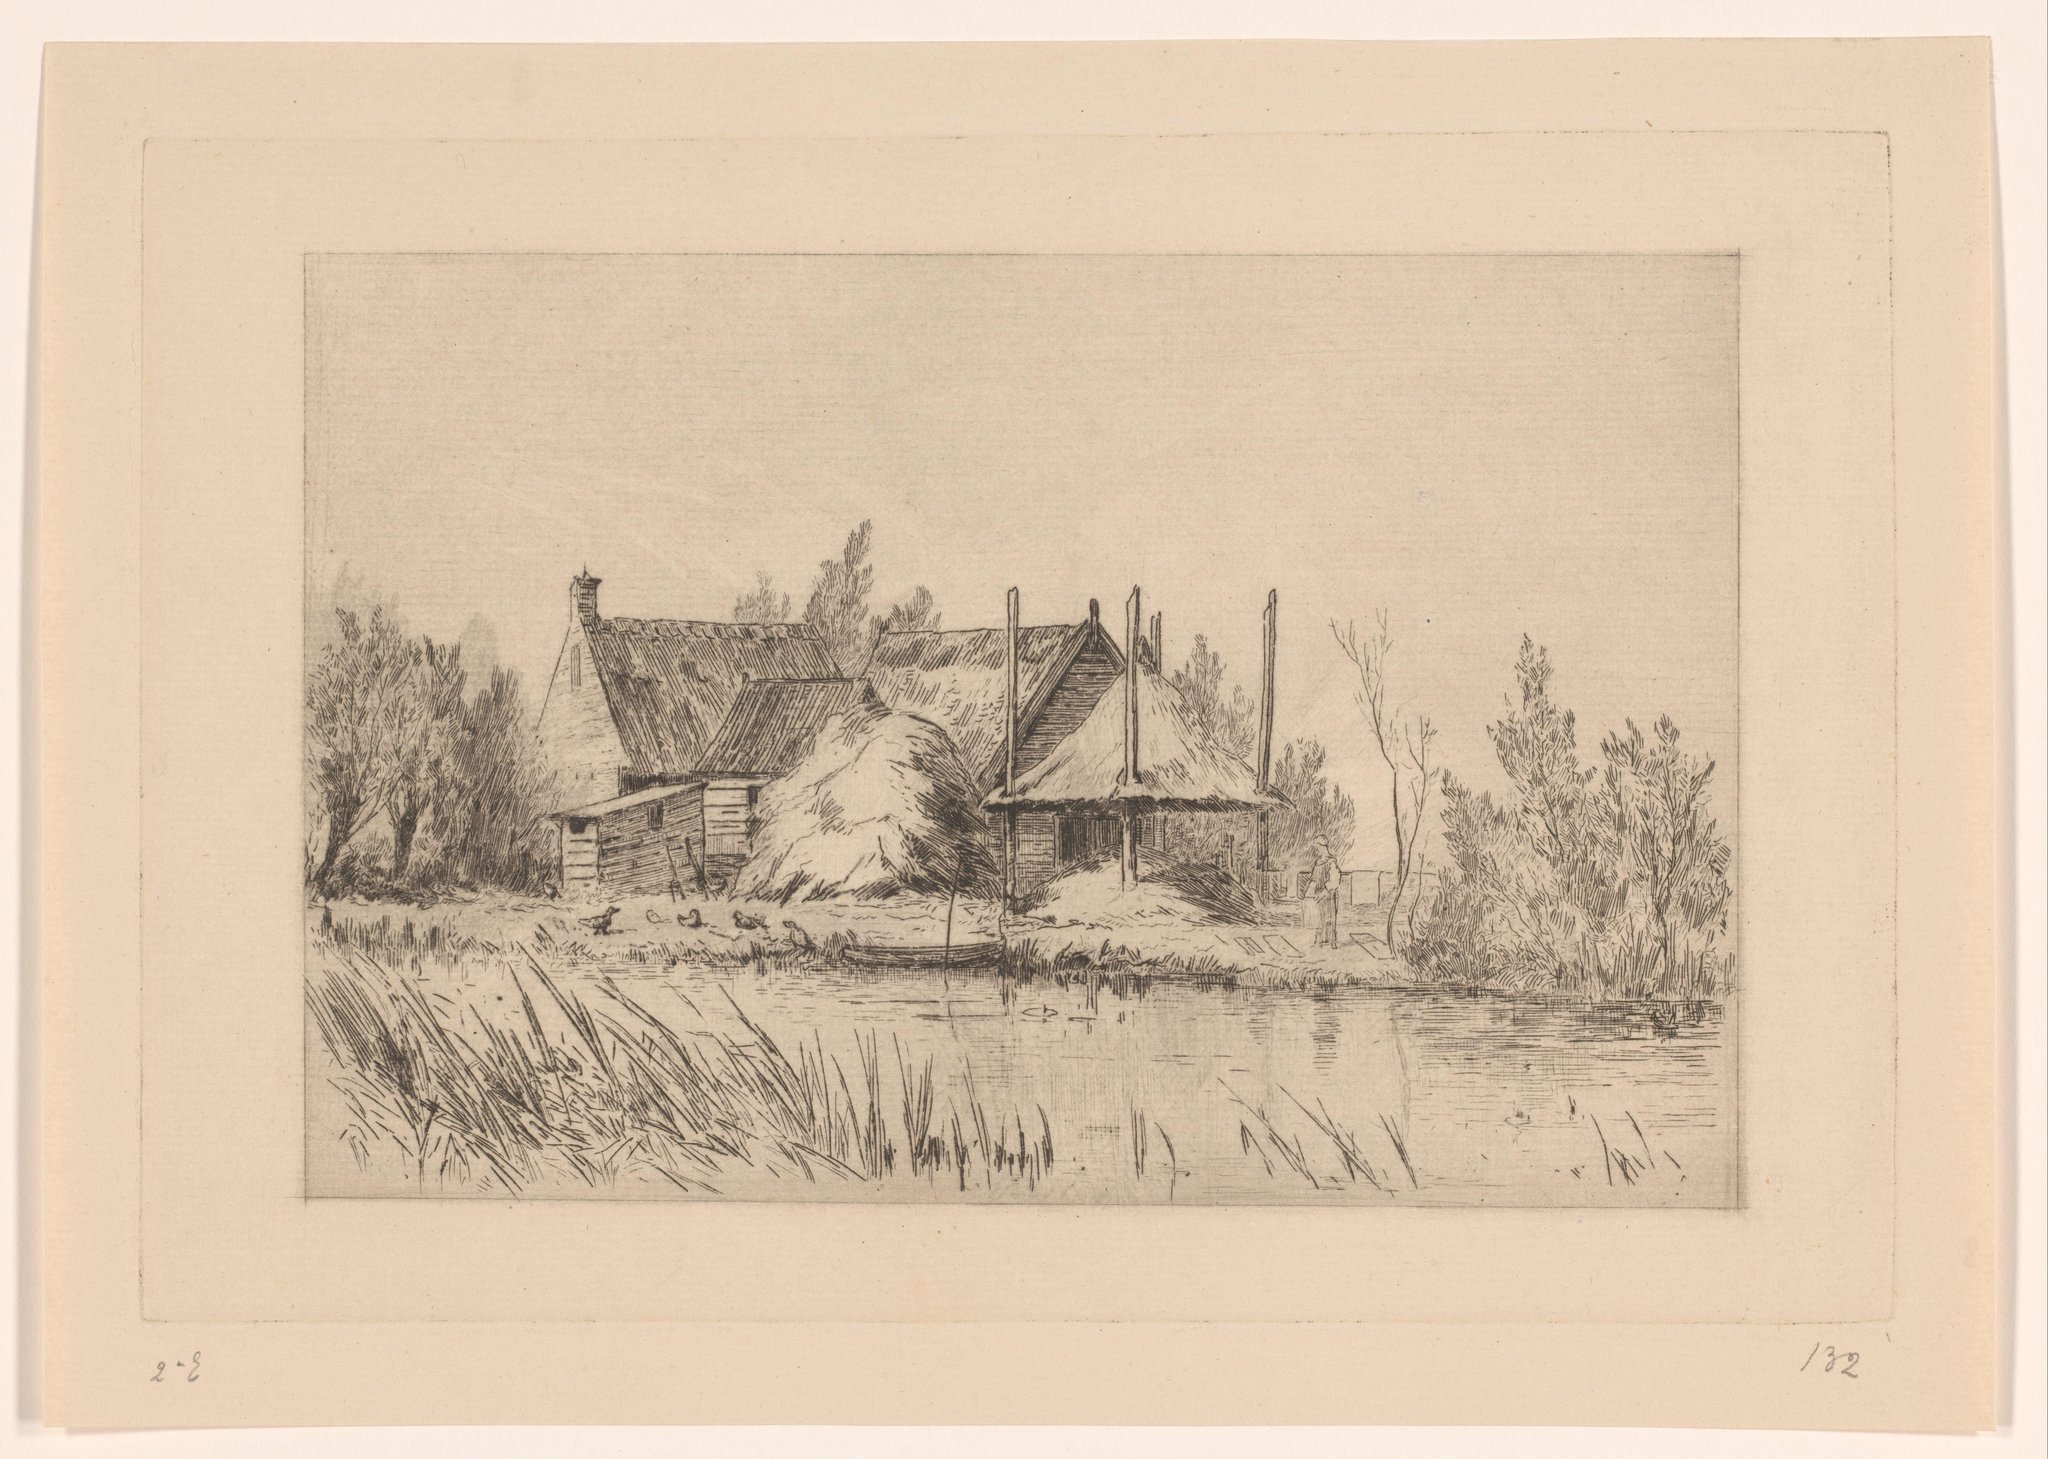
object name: print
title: Sketches of Holland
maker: carel nicolaas storm van s-gravesande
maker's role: draughtsman, print maker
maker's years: 1841-1924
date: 1880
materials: paper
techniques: etching, intaglio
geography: netherlands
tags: hay-stack, farm or solitary house in landscape (+ city(-scape) with figures, staffage), abcoude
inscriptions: collector's mark: Lugt 2228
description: Gezicht op een boerderij met een hooiberg. Rechts staat een vrouw de was te doen.